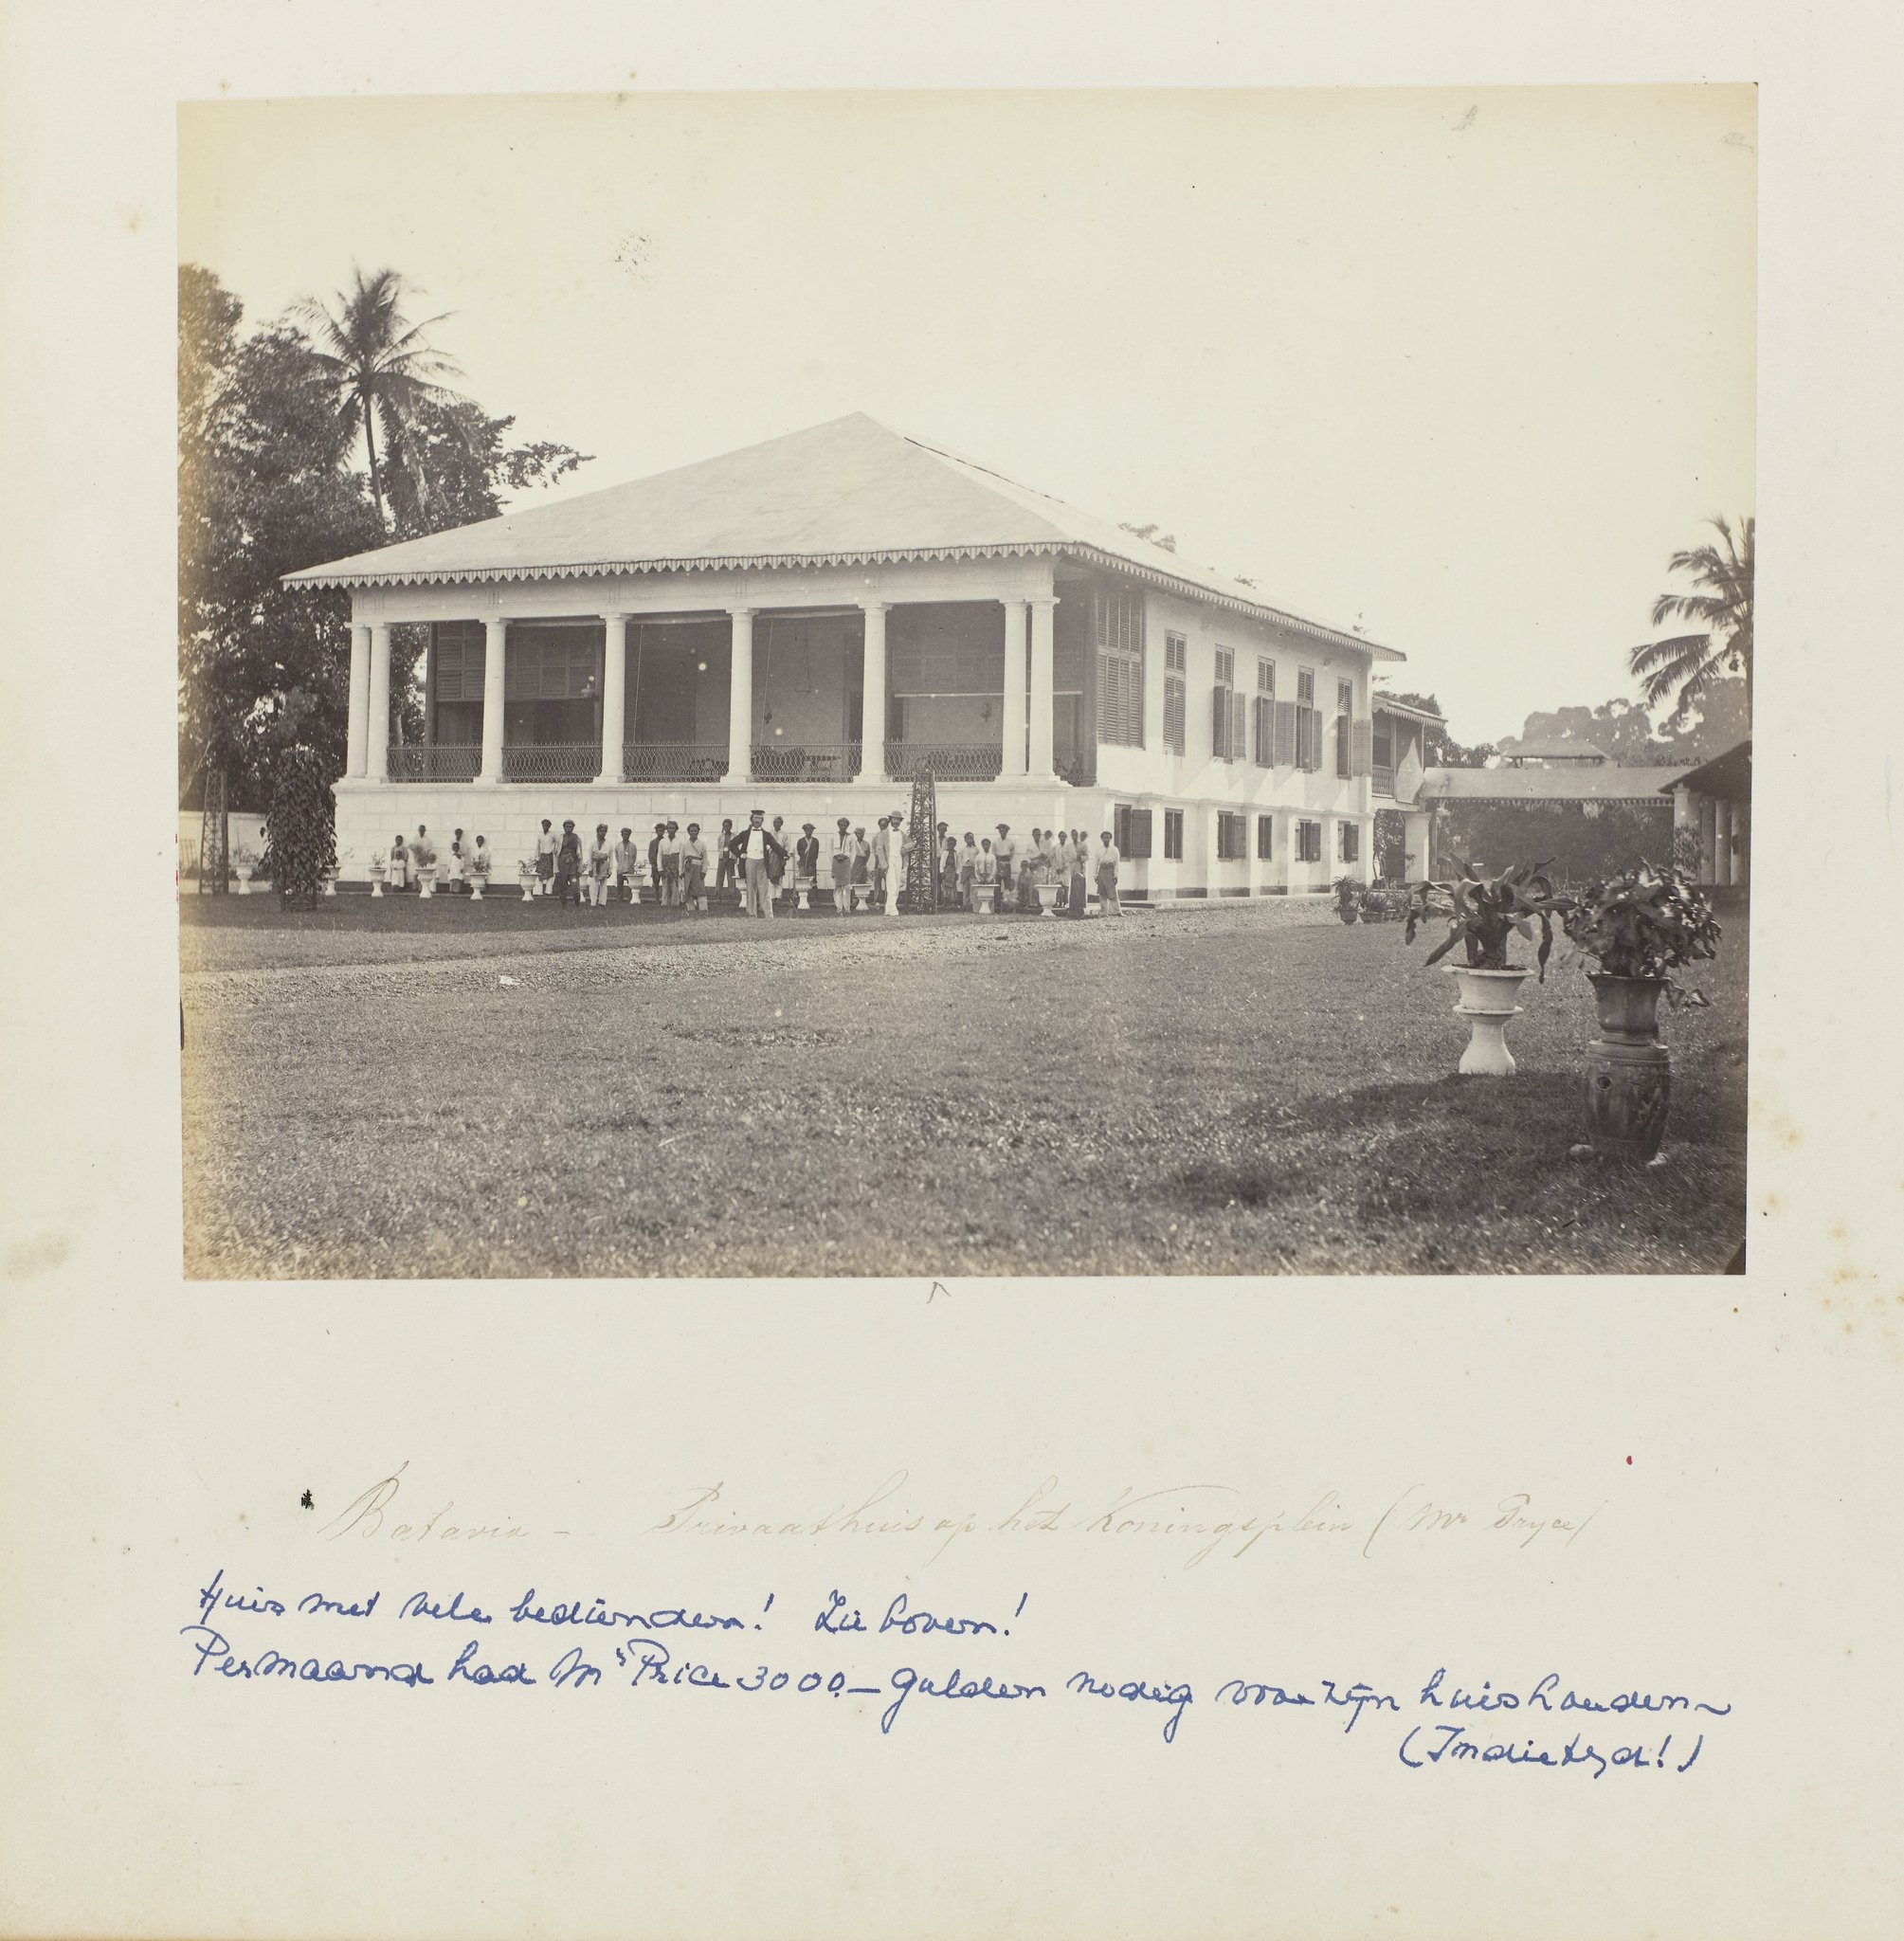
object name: photograph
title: Batavia - Privaathuis op het Koningsplein (mr. Pryce)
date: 1863-1866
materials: photographic support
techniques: albumen print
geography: batavia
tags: detached house in city, batavia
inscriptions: inscription: ‘Batavia - Privaathuis op het Koningsplein (mr. Pryce)’, inscription: ‘Huis met vele bedienden! Zie boven! Per maand had Mr. Price 3000.- gulden nodig voor zijn huishouden (In die tijd!)’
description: Het woonhuis van John Pryce aan het Koningsplein te Batavia. Pryce poseert samen met zijn compagnon Willem van der Hucht voor zijn huis met voltallig personeel. Onderdeel van het rode fotoalbum met foto's van Java, uit het bezit van apotheker Specht-Grijp, die in 1865 vanuit Batavia naar Nederland terugkeerde.